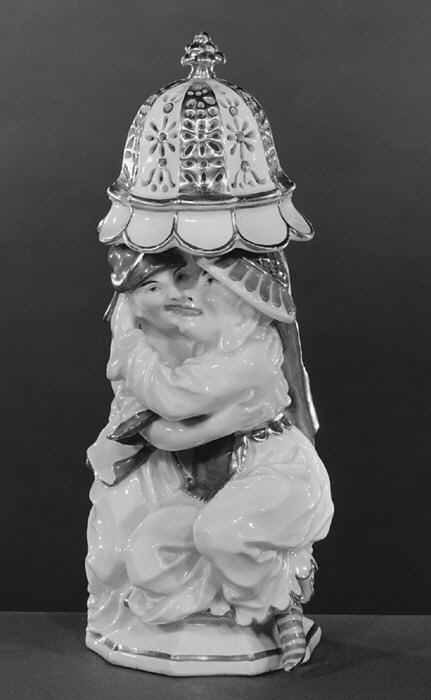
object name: sugar caster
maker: meissen manufactory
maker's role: manufactory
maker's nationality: german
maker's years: 1710-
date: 1740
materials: hard paste porcelain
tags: men,women